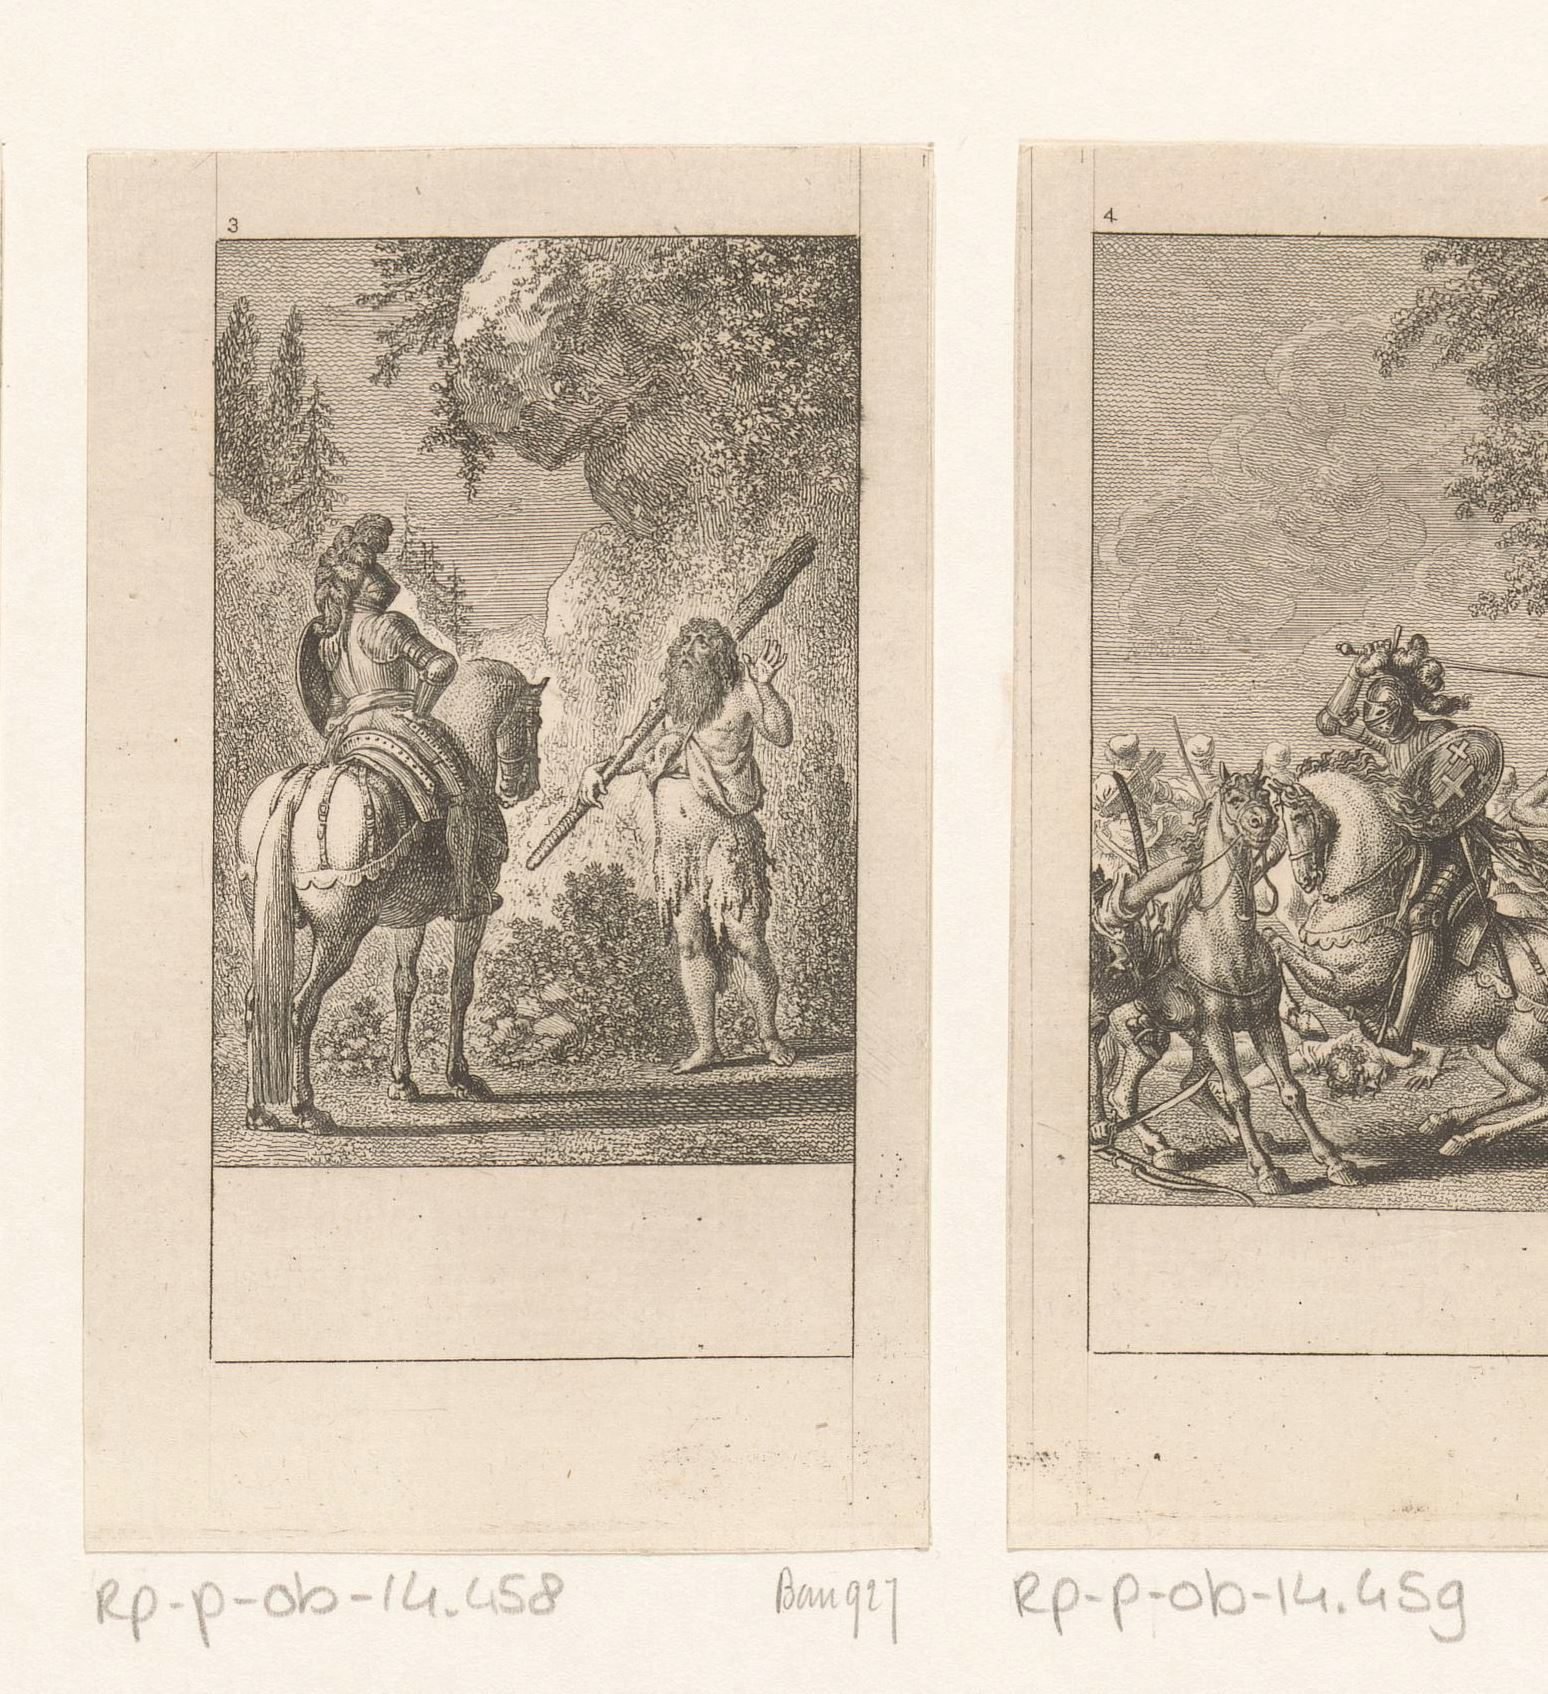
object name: print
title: Huon de Bordeaux ontmoet de wildeman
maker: daniel nikolaus chodowiecki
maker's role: draughtsman, print maker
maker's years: 1726-1801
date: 1782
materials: paper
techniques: etching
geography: berlin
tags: riding a horse, ass, or mule; rider, horseman, wild man, wodewose, woodehouse, armour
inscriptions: collector's mark: Lugt 2228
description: Vervaardigd voor Tressans 'Huon de Bordeaux'. Latere staat gebruikt voor: Almanac de Gotha contenant diverses connaissances curieuses et utiles pour l'année MDCCLXXXIII. Gotha: C. W. Ettinger, 1782.